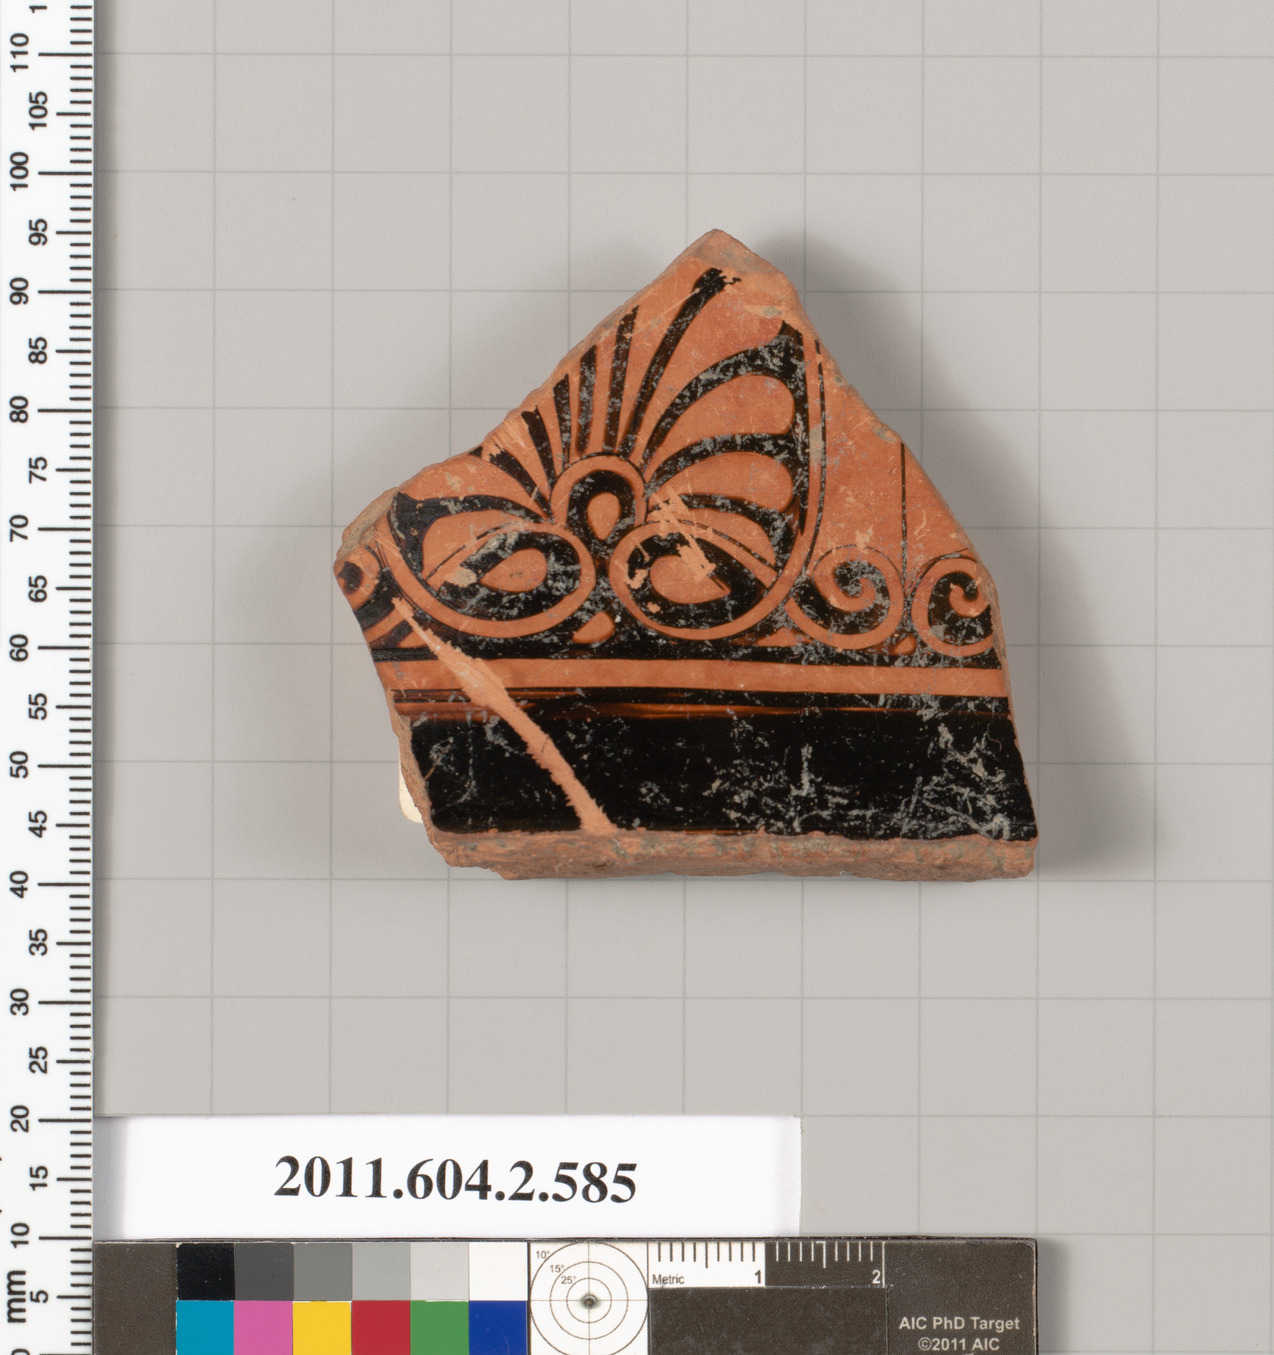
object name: column krater fragment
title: Terracotta fragment of a column-krater (bowl for mixing wine and water)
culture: greek, attic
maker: orchard painter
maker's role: artist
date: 460-450 BCE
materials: terracotta